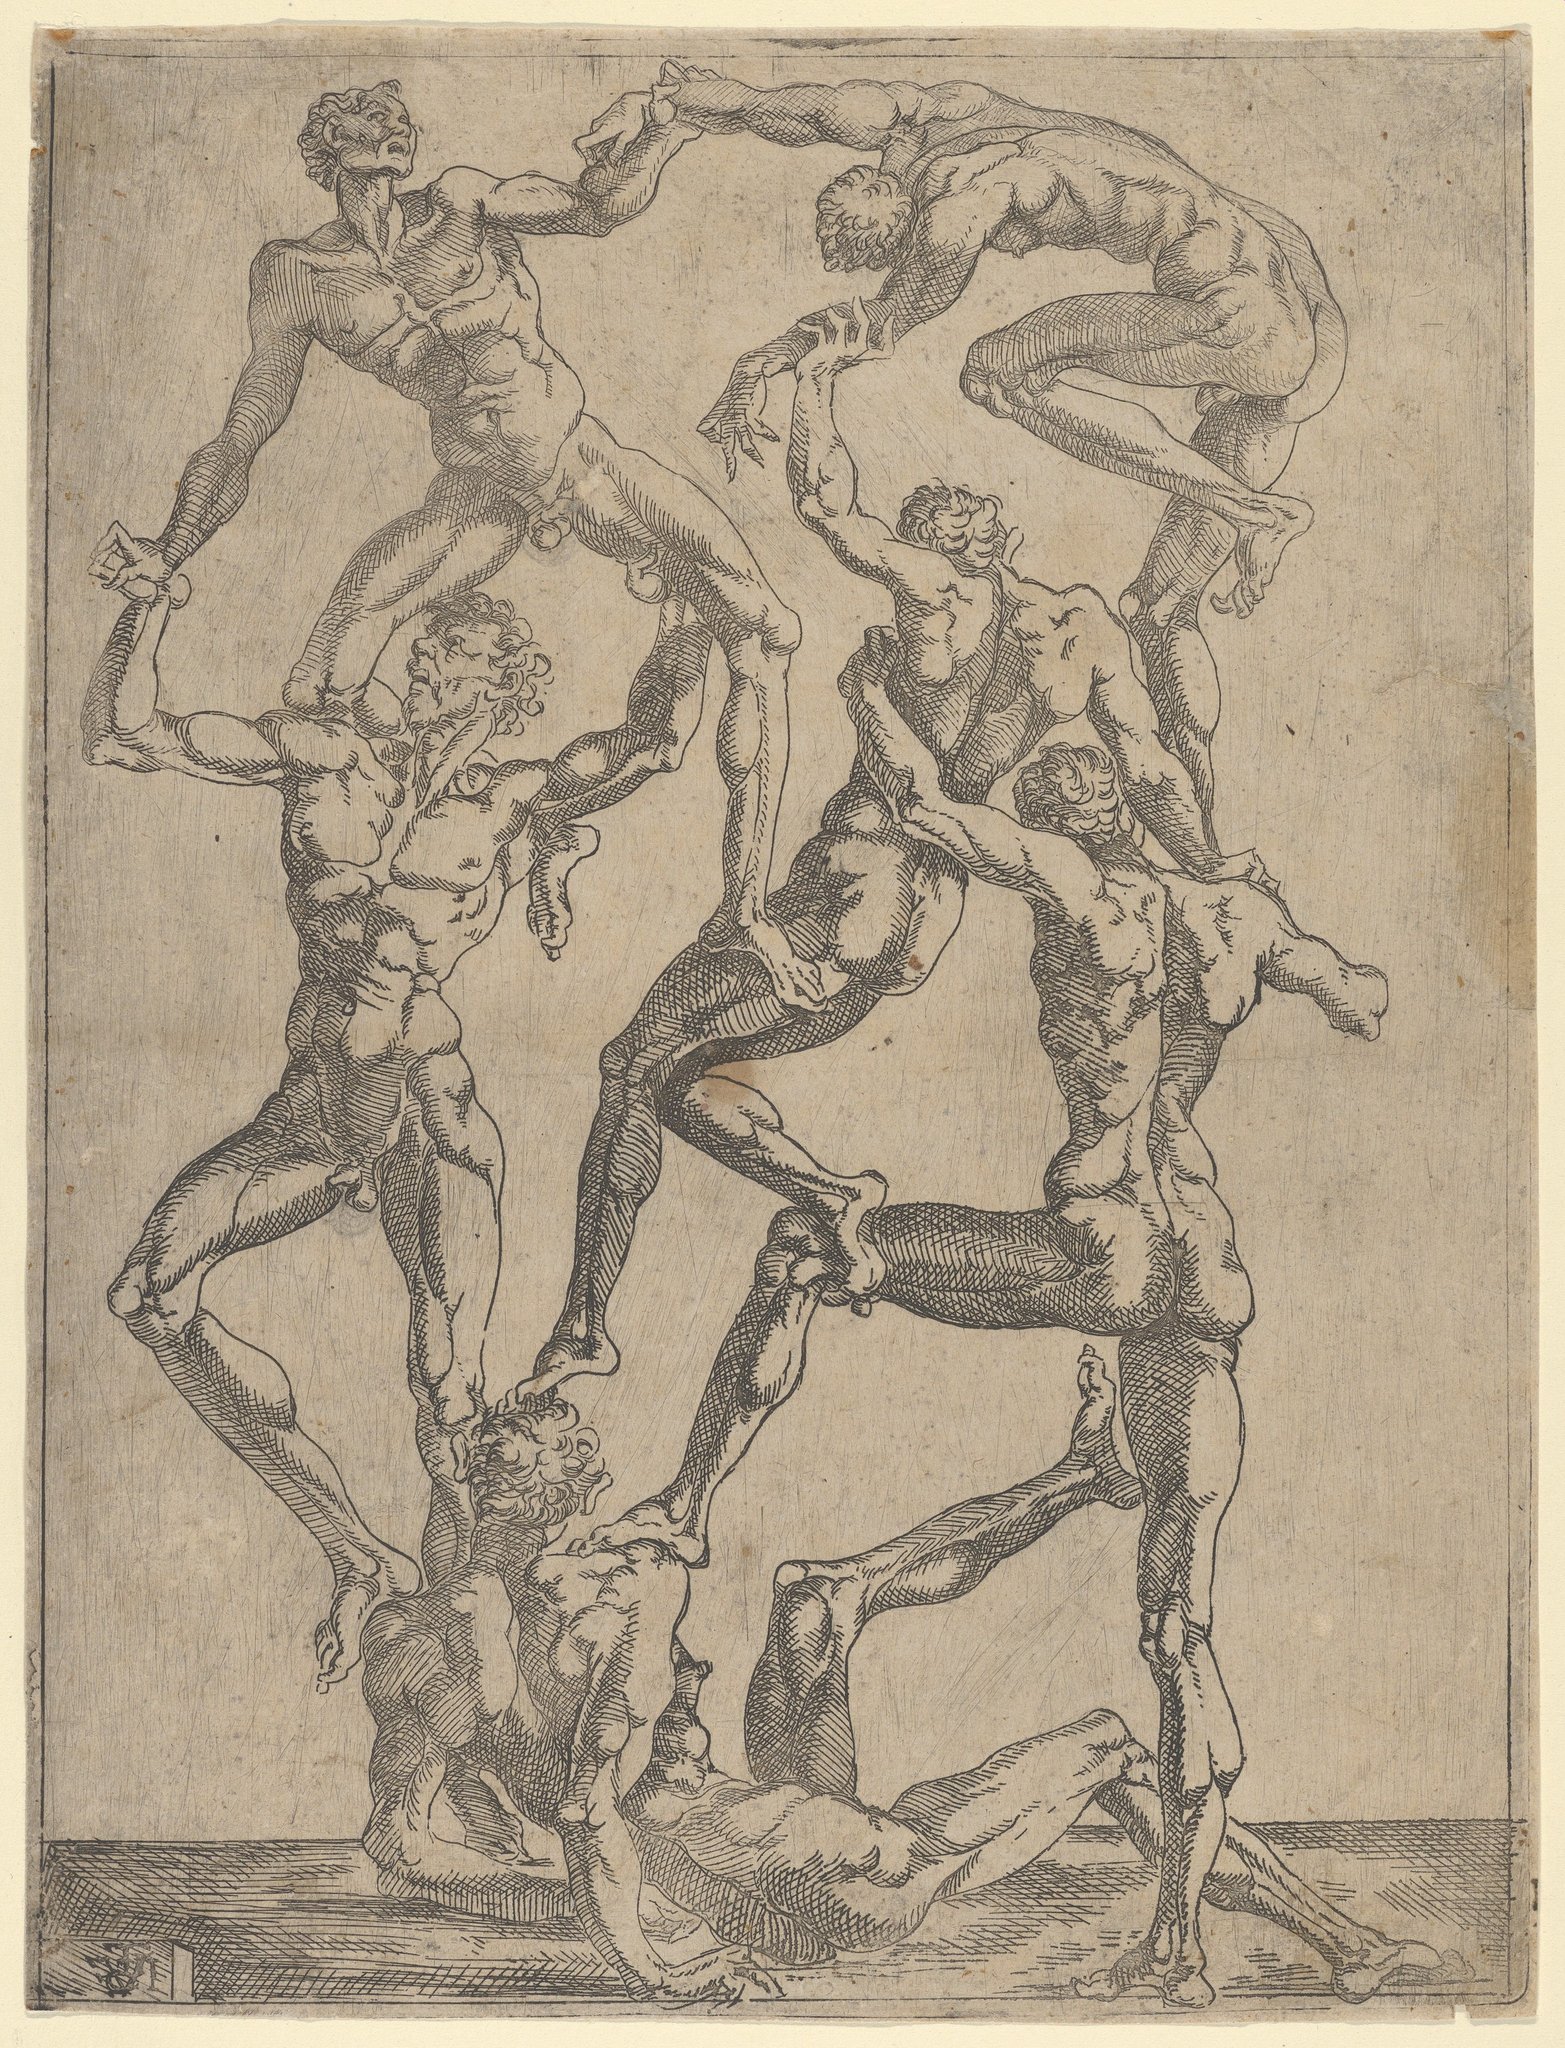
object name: print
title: Pyramid of six Men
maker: juste de juste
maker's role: artist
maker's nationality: french, born italy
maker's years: 1505-1559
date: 1540-1550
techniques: etching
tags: performance,male nudes